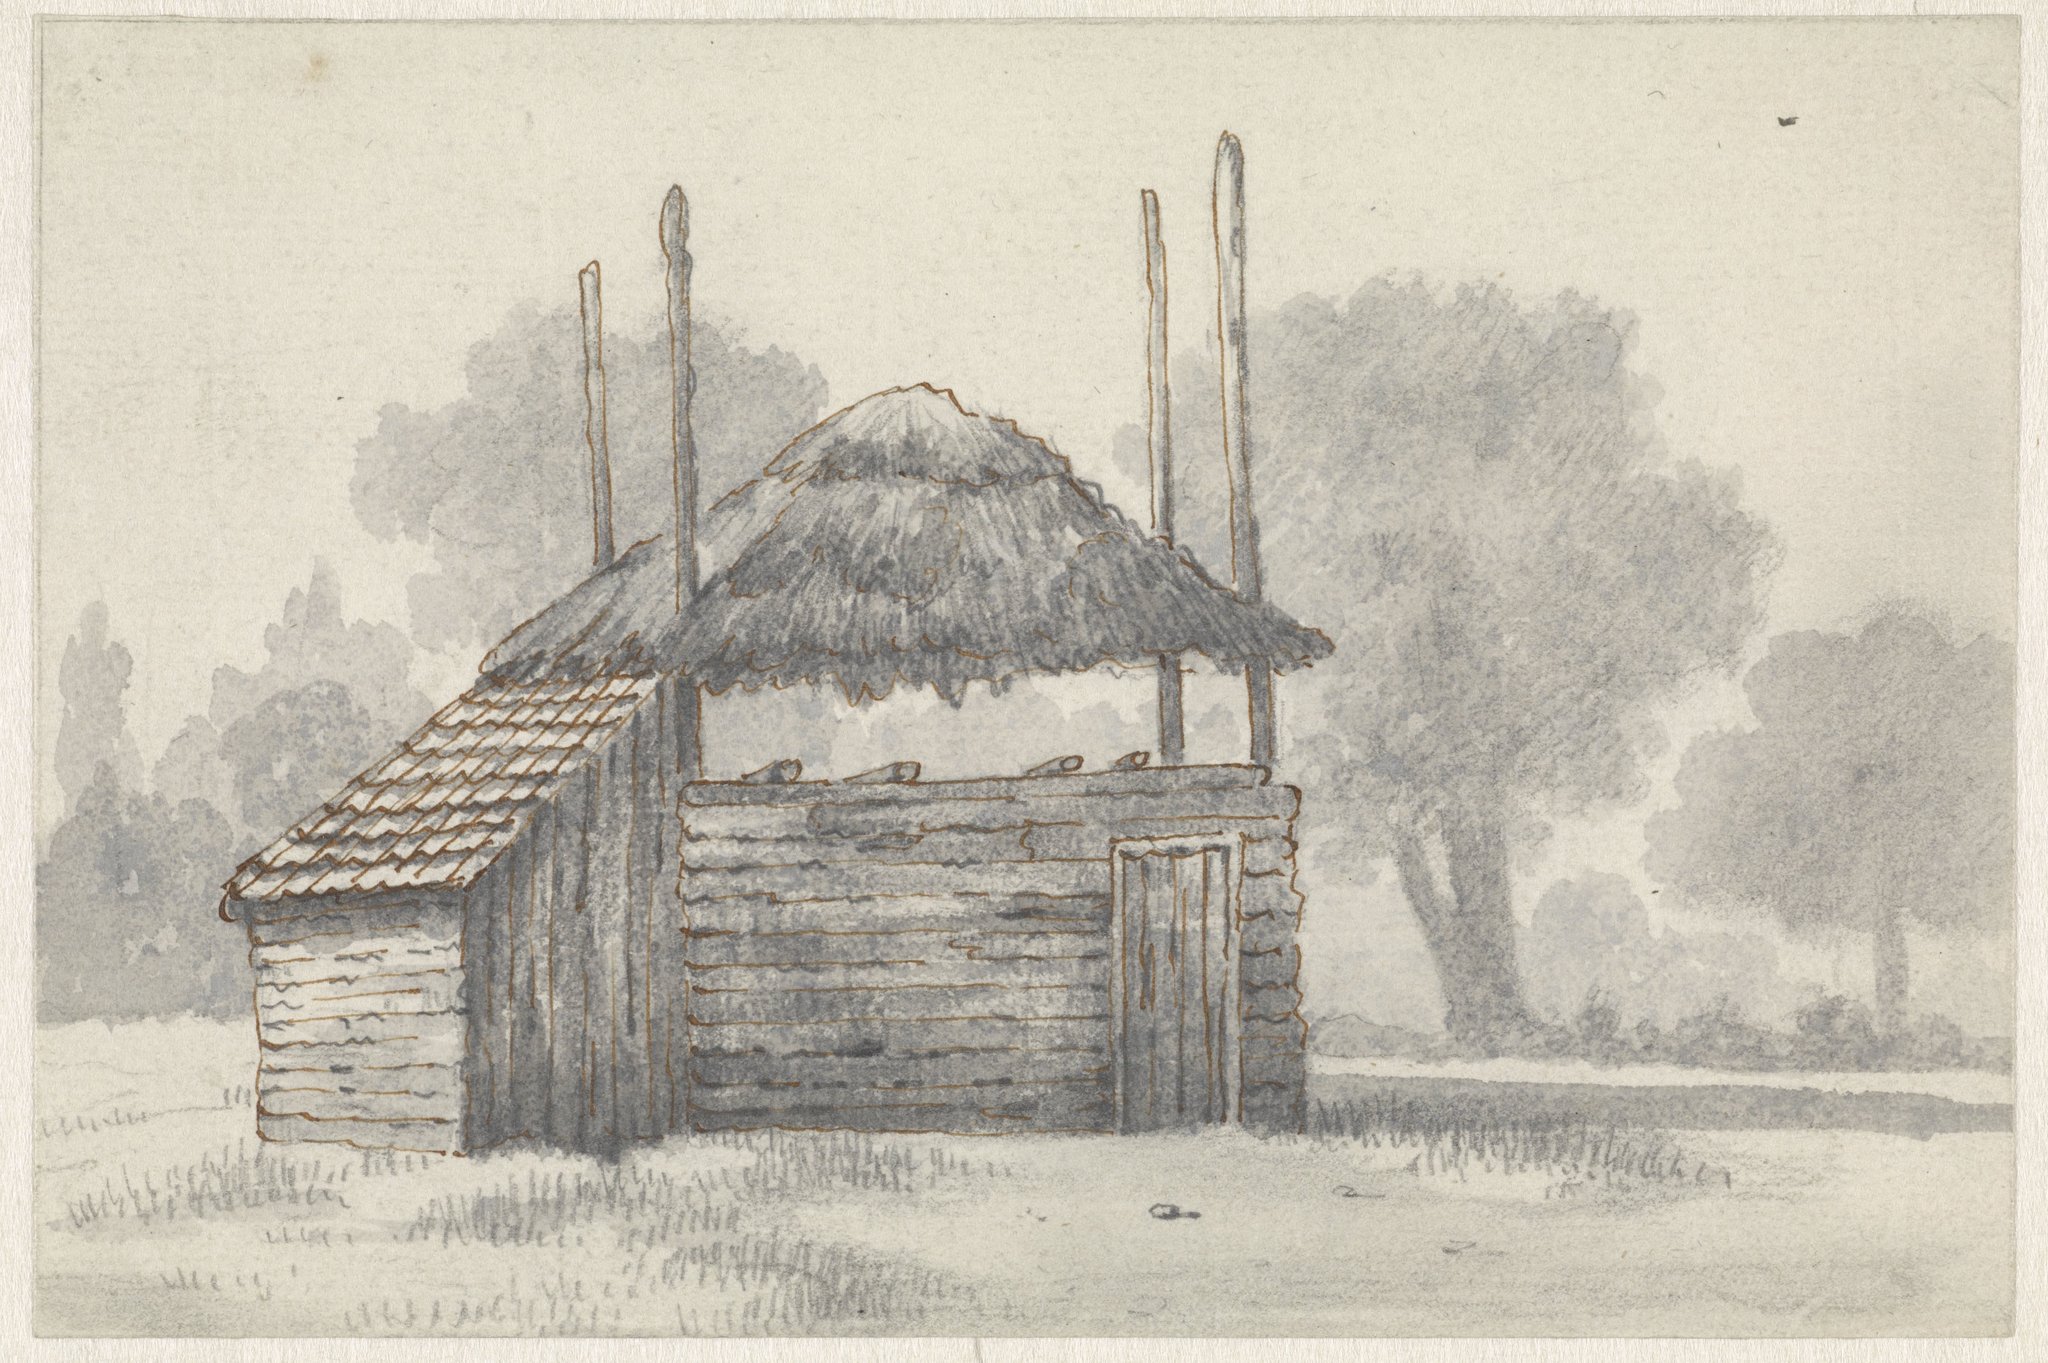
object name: drawing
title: Hooischelf te Zoelmond, in de Betuwe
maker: evert doublet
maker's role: draughtsman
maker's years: 1802-1859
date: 1812-1859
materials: ink, paper, pencil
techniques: brush, pen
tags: hay-stack